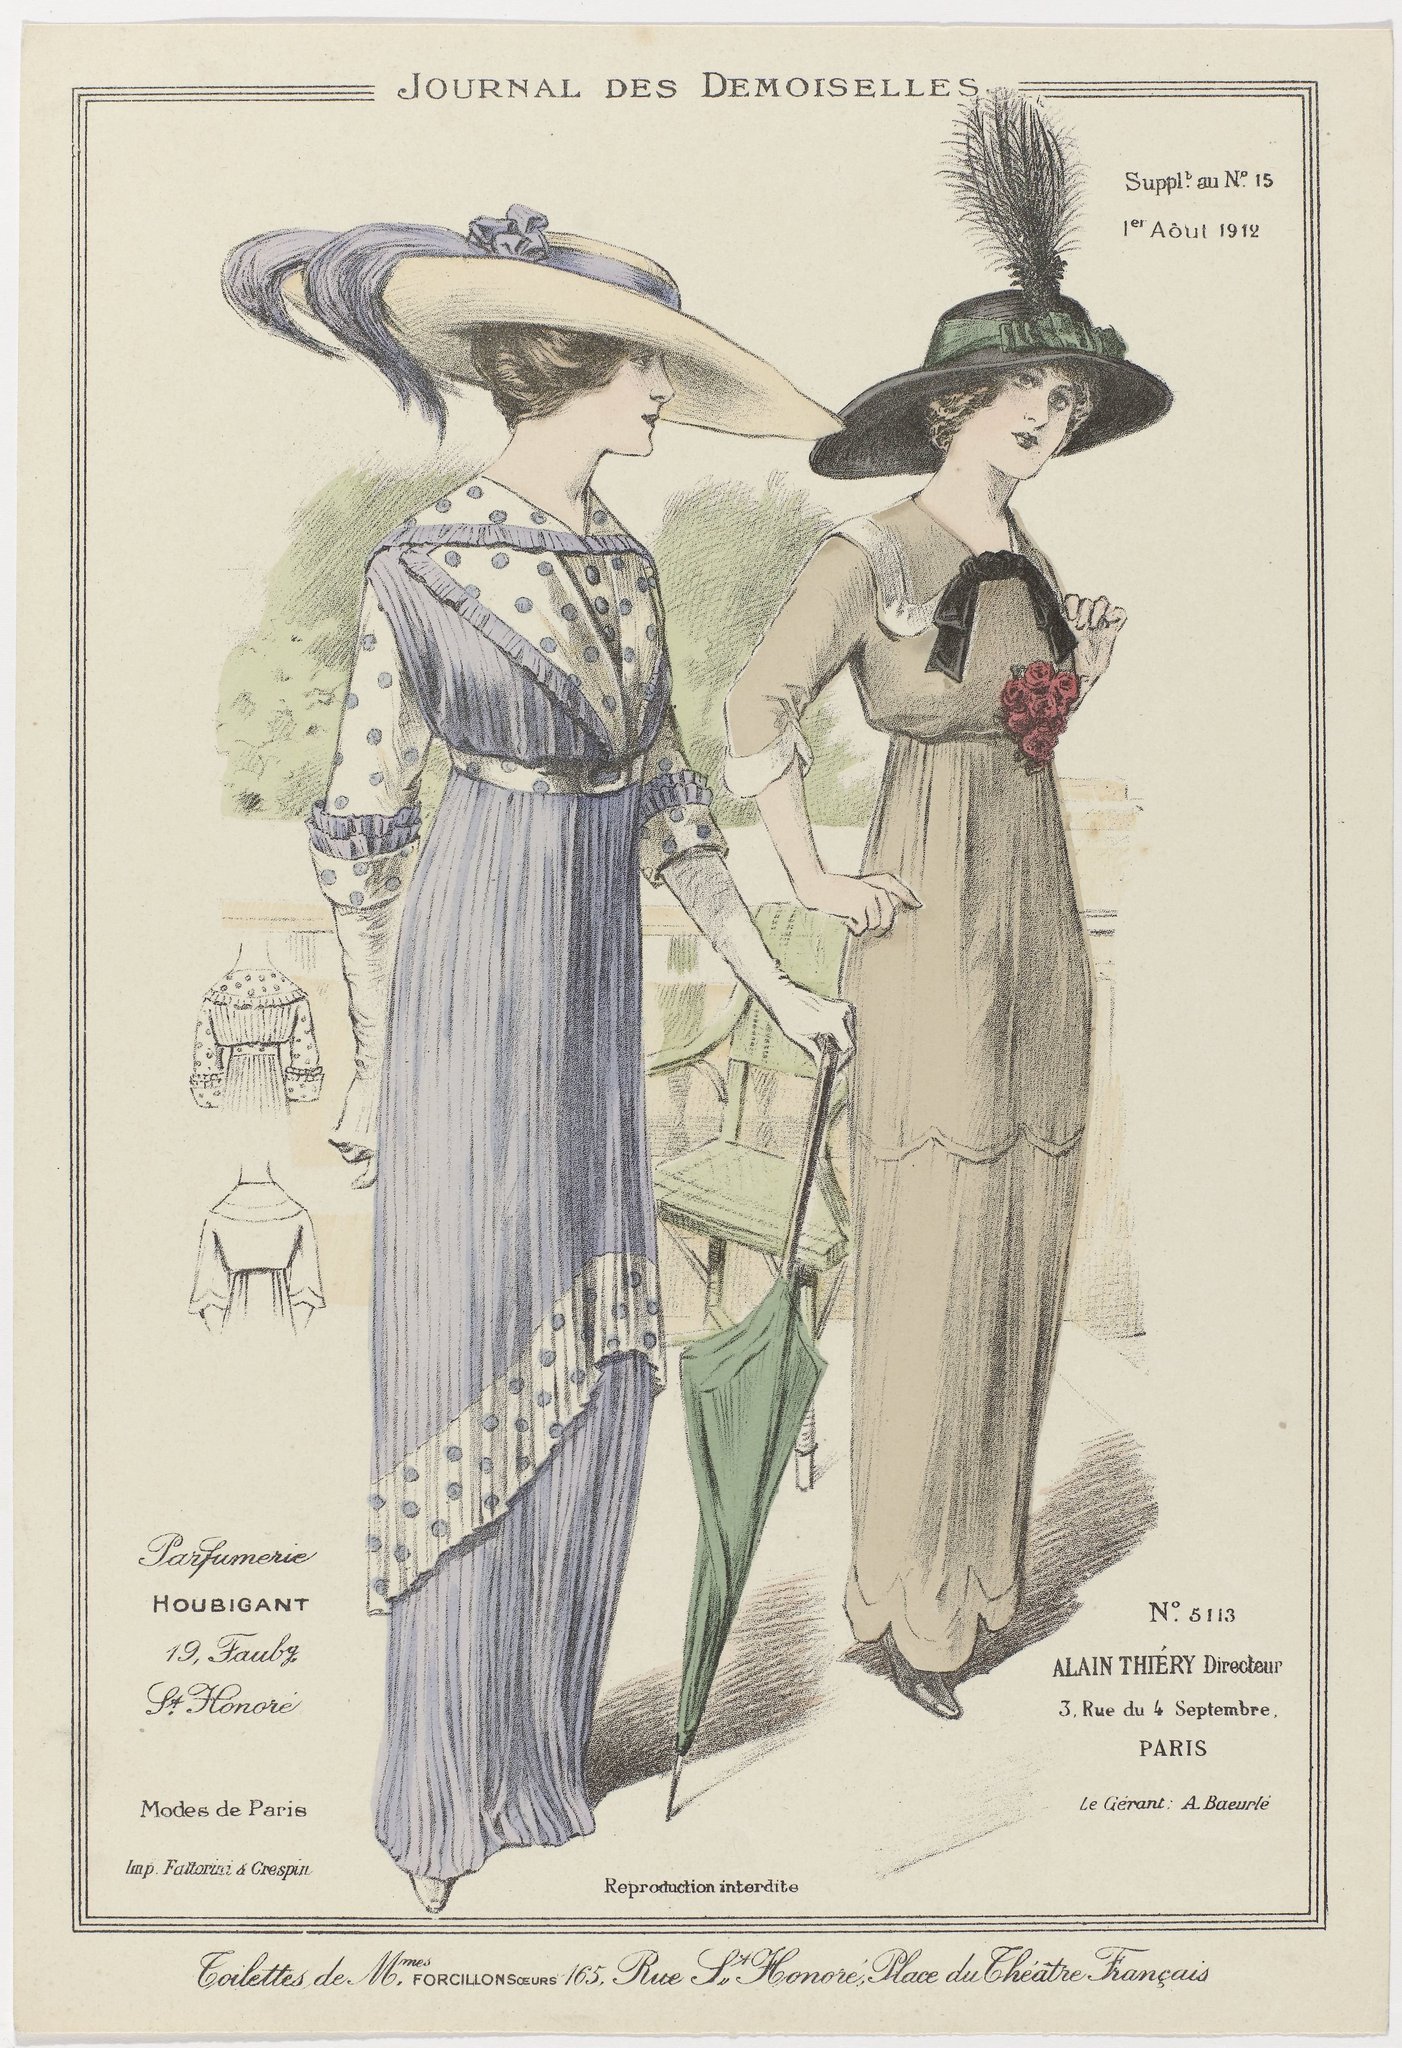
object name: fashion print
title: Journal des Demoiselles, Suplement au No. 15, 1 Août 1912, No. 5113 : Toilettes de Mmes Forcillon (...)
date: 1912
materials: paper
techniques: hand coloring, lithograph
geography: paris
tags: corsage (+ women's clothes), walking-stick, staff, cane (+ women's clothes), dress, gown (tunic) (+ women's clothes), fashion plates, head-gear: hat (+ women's clothes), skirt (+ women's clothes), dress, gown (+ women's clothes), belt, girdle, waistband (+ women's clothes)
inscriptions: caption: ‘Toilettes de M.mes FORCILLON SOEURS 165, Rue S.t Honoré, Place du Théâtre Français’, inscription: ‘Parfumerie HOUBIGANT 19, Faub.g S.t Honoré’, title: ‘JOURNAL DES DEMOISELLES’, title: ‘Modes de Paris’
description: De vrouw links draagt een gerimpelde japon, bestaande uit tuniek en onderrok. De revers, halflange mouwen, ceintuur en zoom hebben een stippenmotief. Hoed met brede rand, versierd met veren. Parasol of paraplu in de hand. Naast haar staat een vrouw in een japon met platte afgeronde schouderkraag met zwarte strik. Driekwart mouwen, hoge taille en geschulpte zoom. Hoed met brede rand en opstaande verenpluim. Bloemcorsage. Volgens het onderschrift:'toilettes' van Mmes Forcillon Soeurs. Prent uit het modetijdschrift Journal des Demoiselles (1833 -1922).